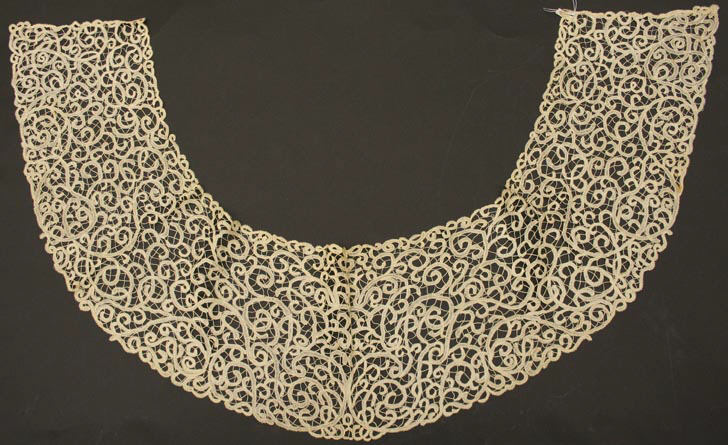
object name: fichu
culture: british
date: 1801-1900